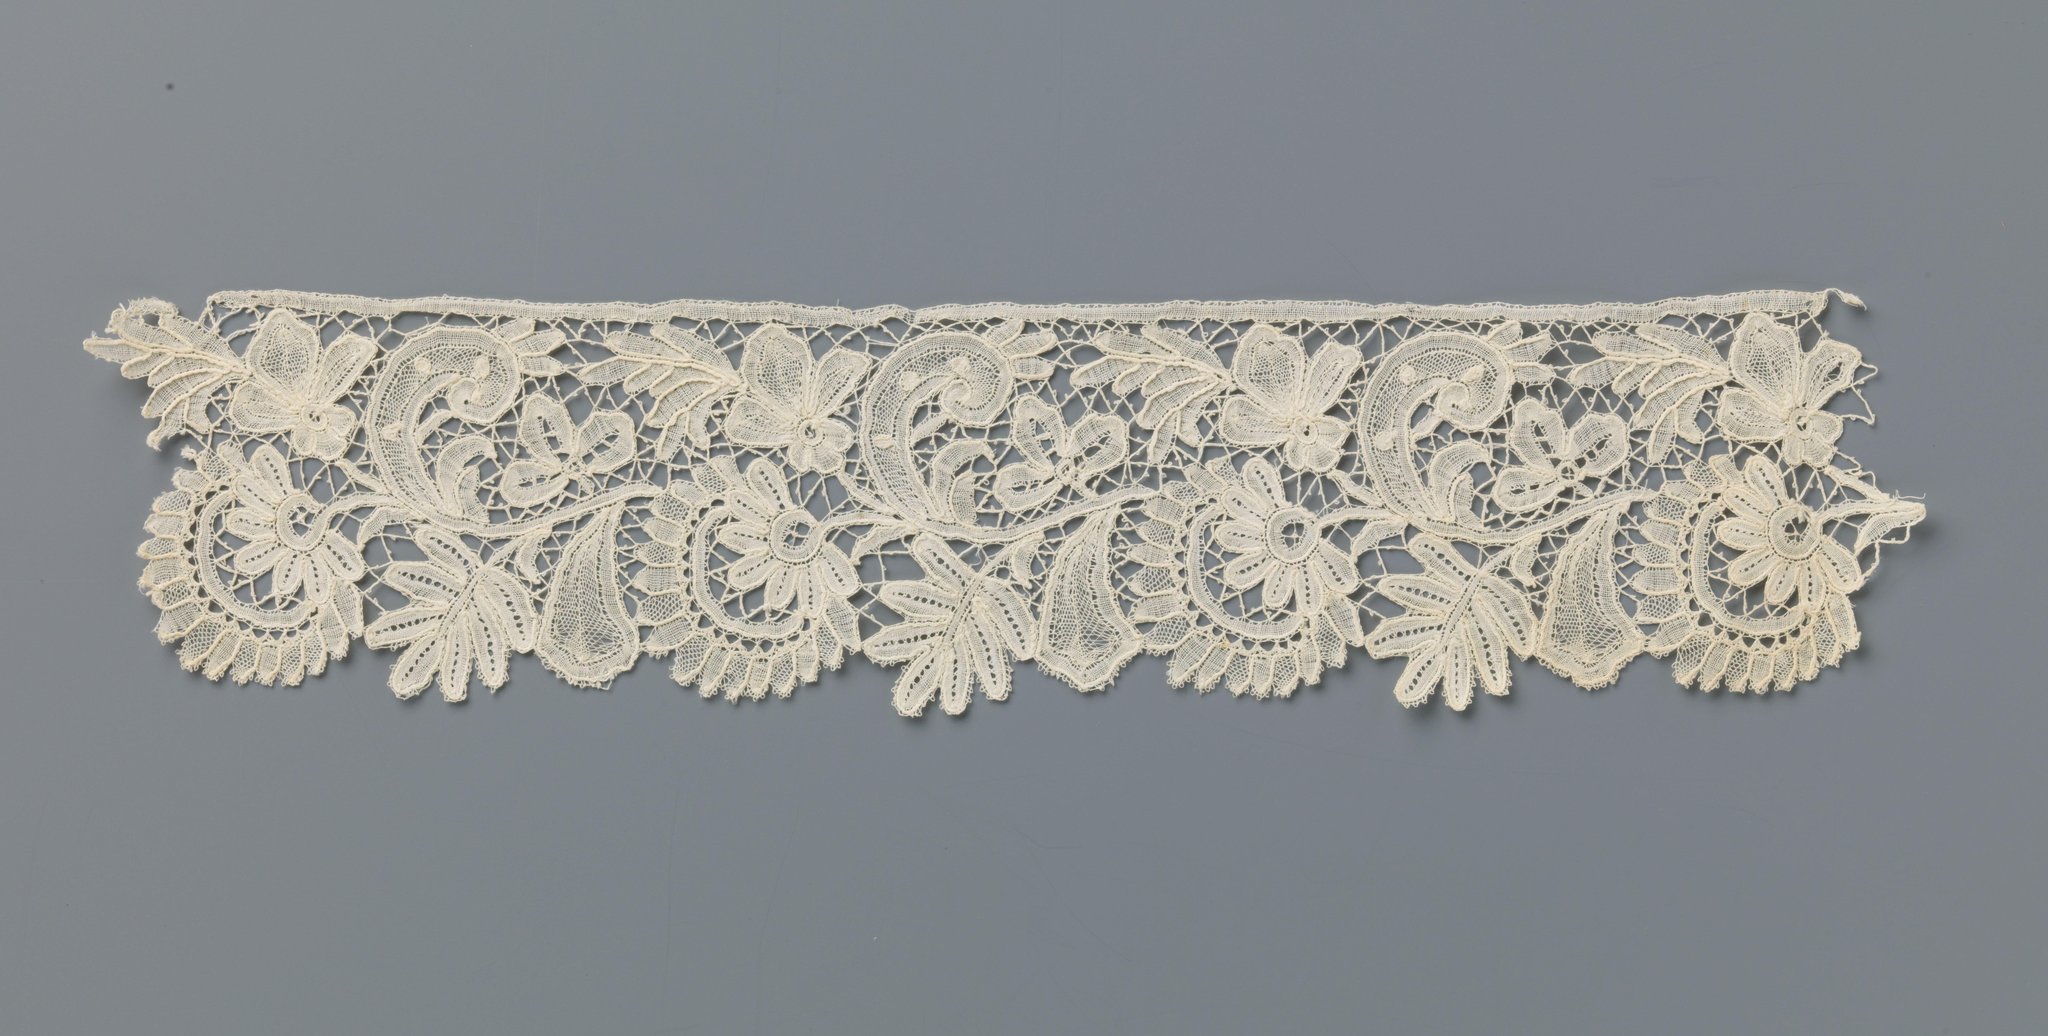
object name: strip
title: Strook kloskant met aster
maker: Anonymous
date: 1900-1924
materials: linen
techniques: lace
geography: netherlands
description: Strook naturelkleurige kloskant: duchesse-kant. Op een open vlechtengrond staat een eenzijdig gerichte lopende rank, die naar binnen eindigt in een brede spiraalrank en naar buiten in een en profil geziene aster.